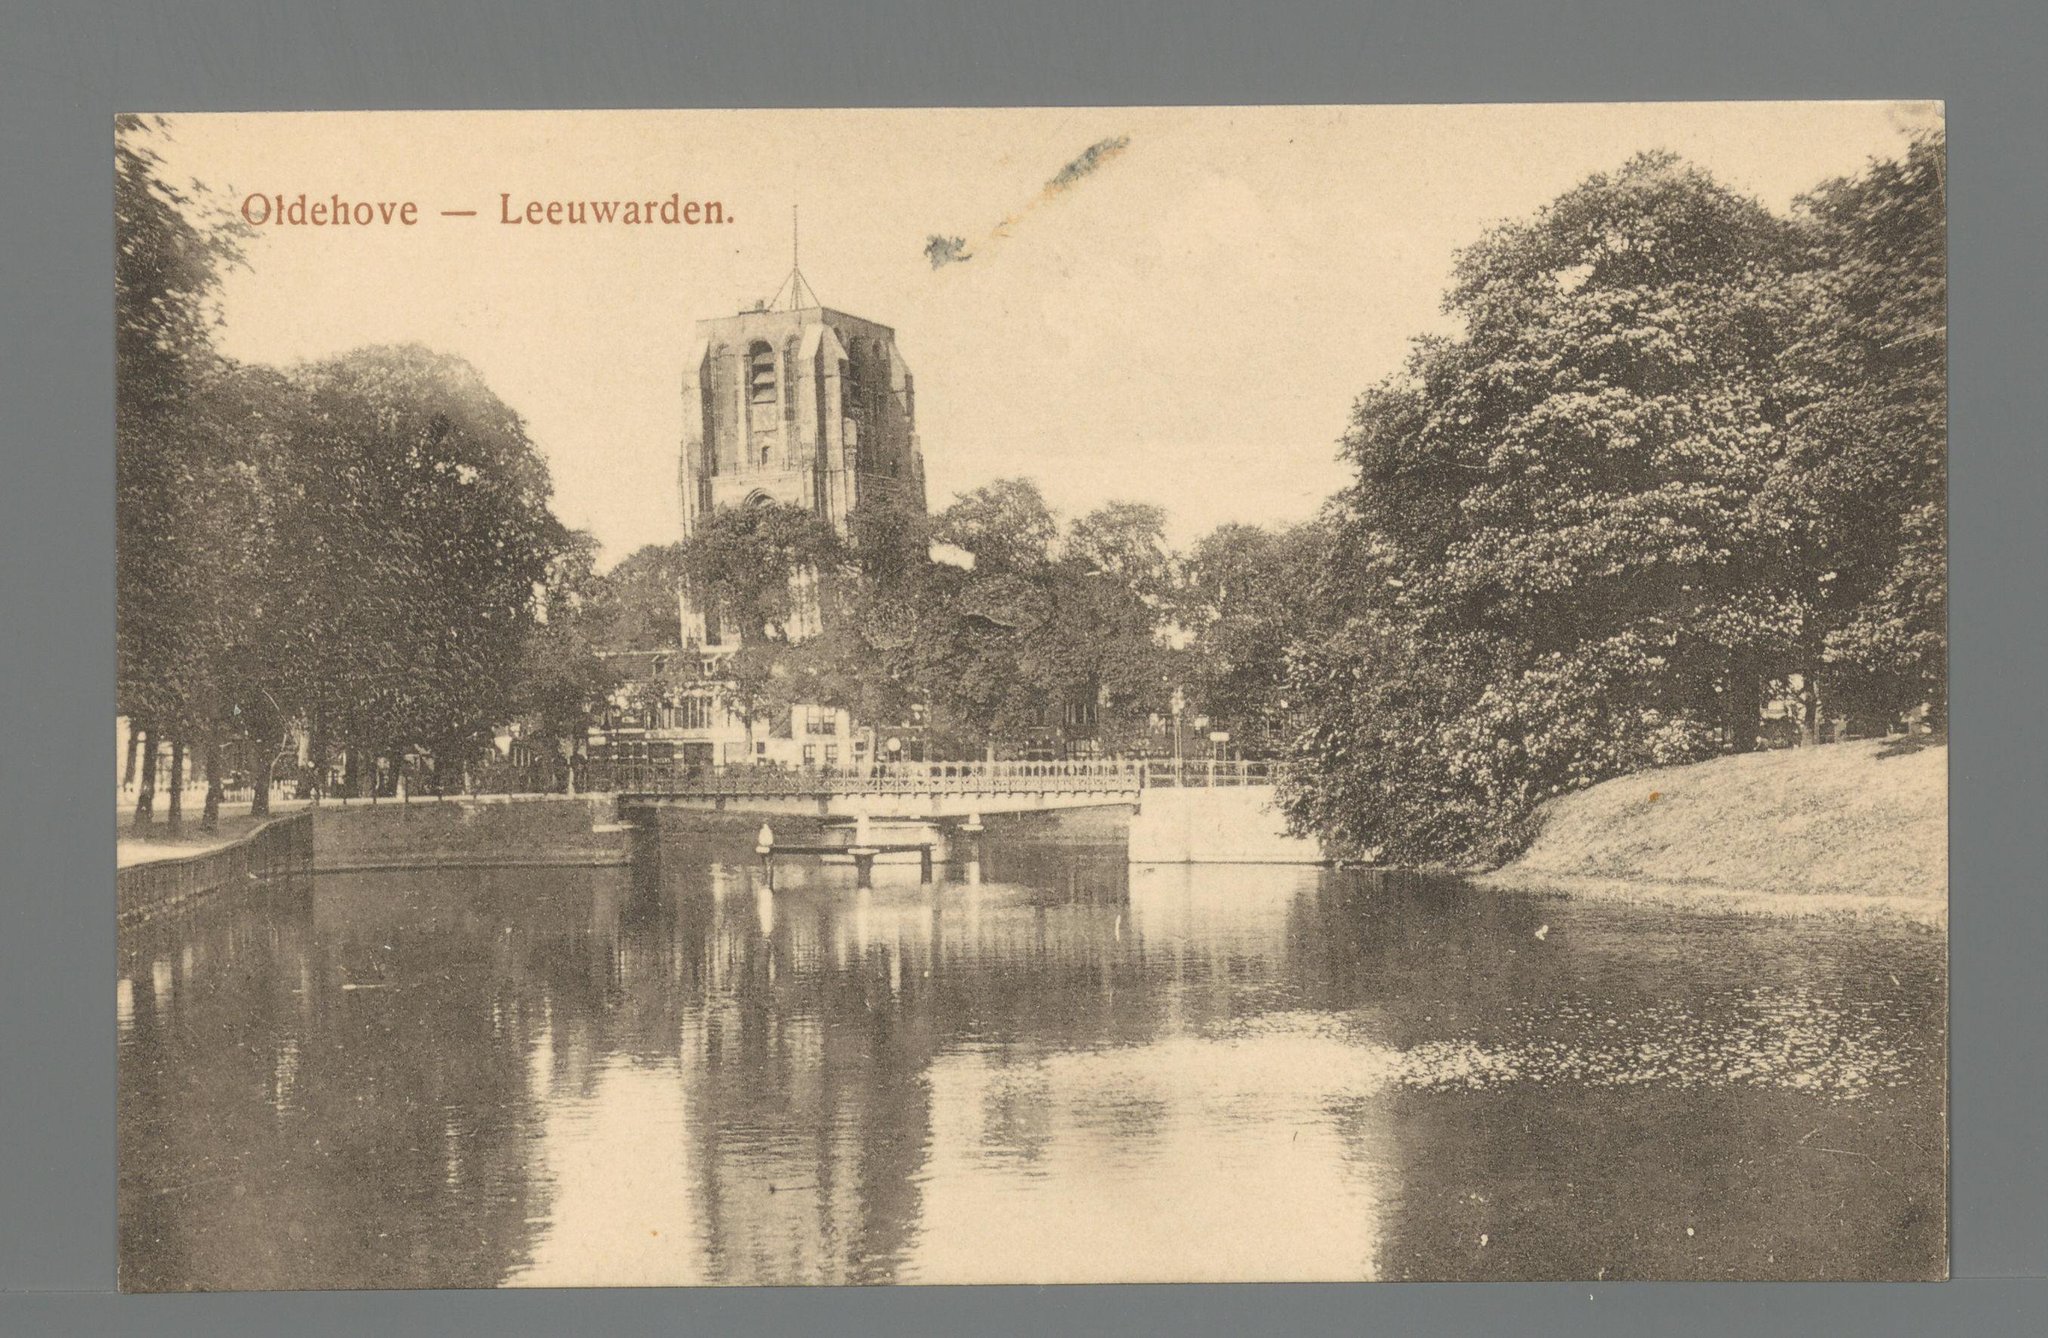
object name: ansichtkaart, prentbriefkaart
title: Oldehove - Leeuwarden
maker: Anonymous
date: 1905-1930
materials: cardboard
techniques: photograph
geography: leeuwarden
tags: church (exterior), canals, waters (in city), bridge in city across river, canal, etc.